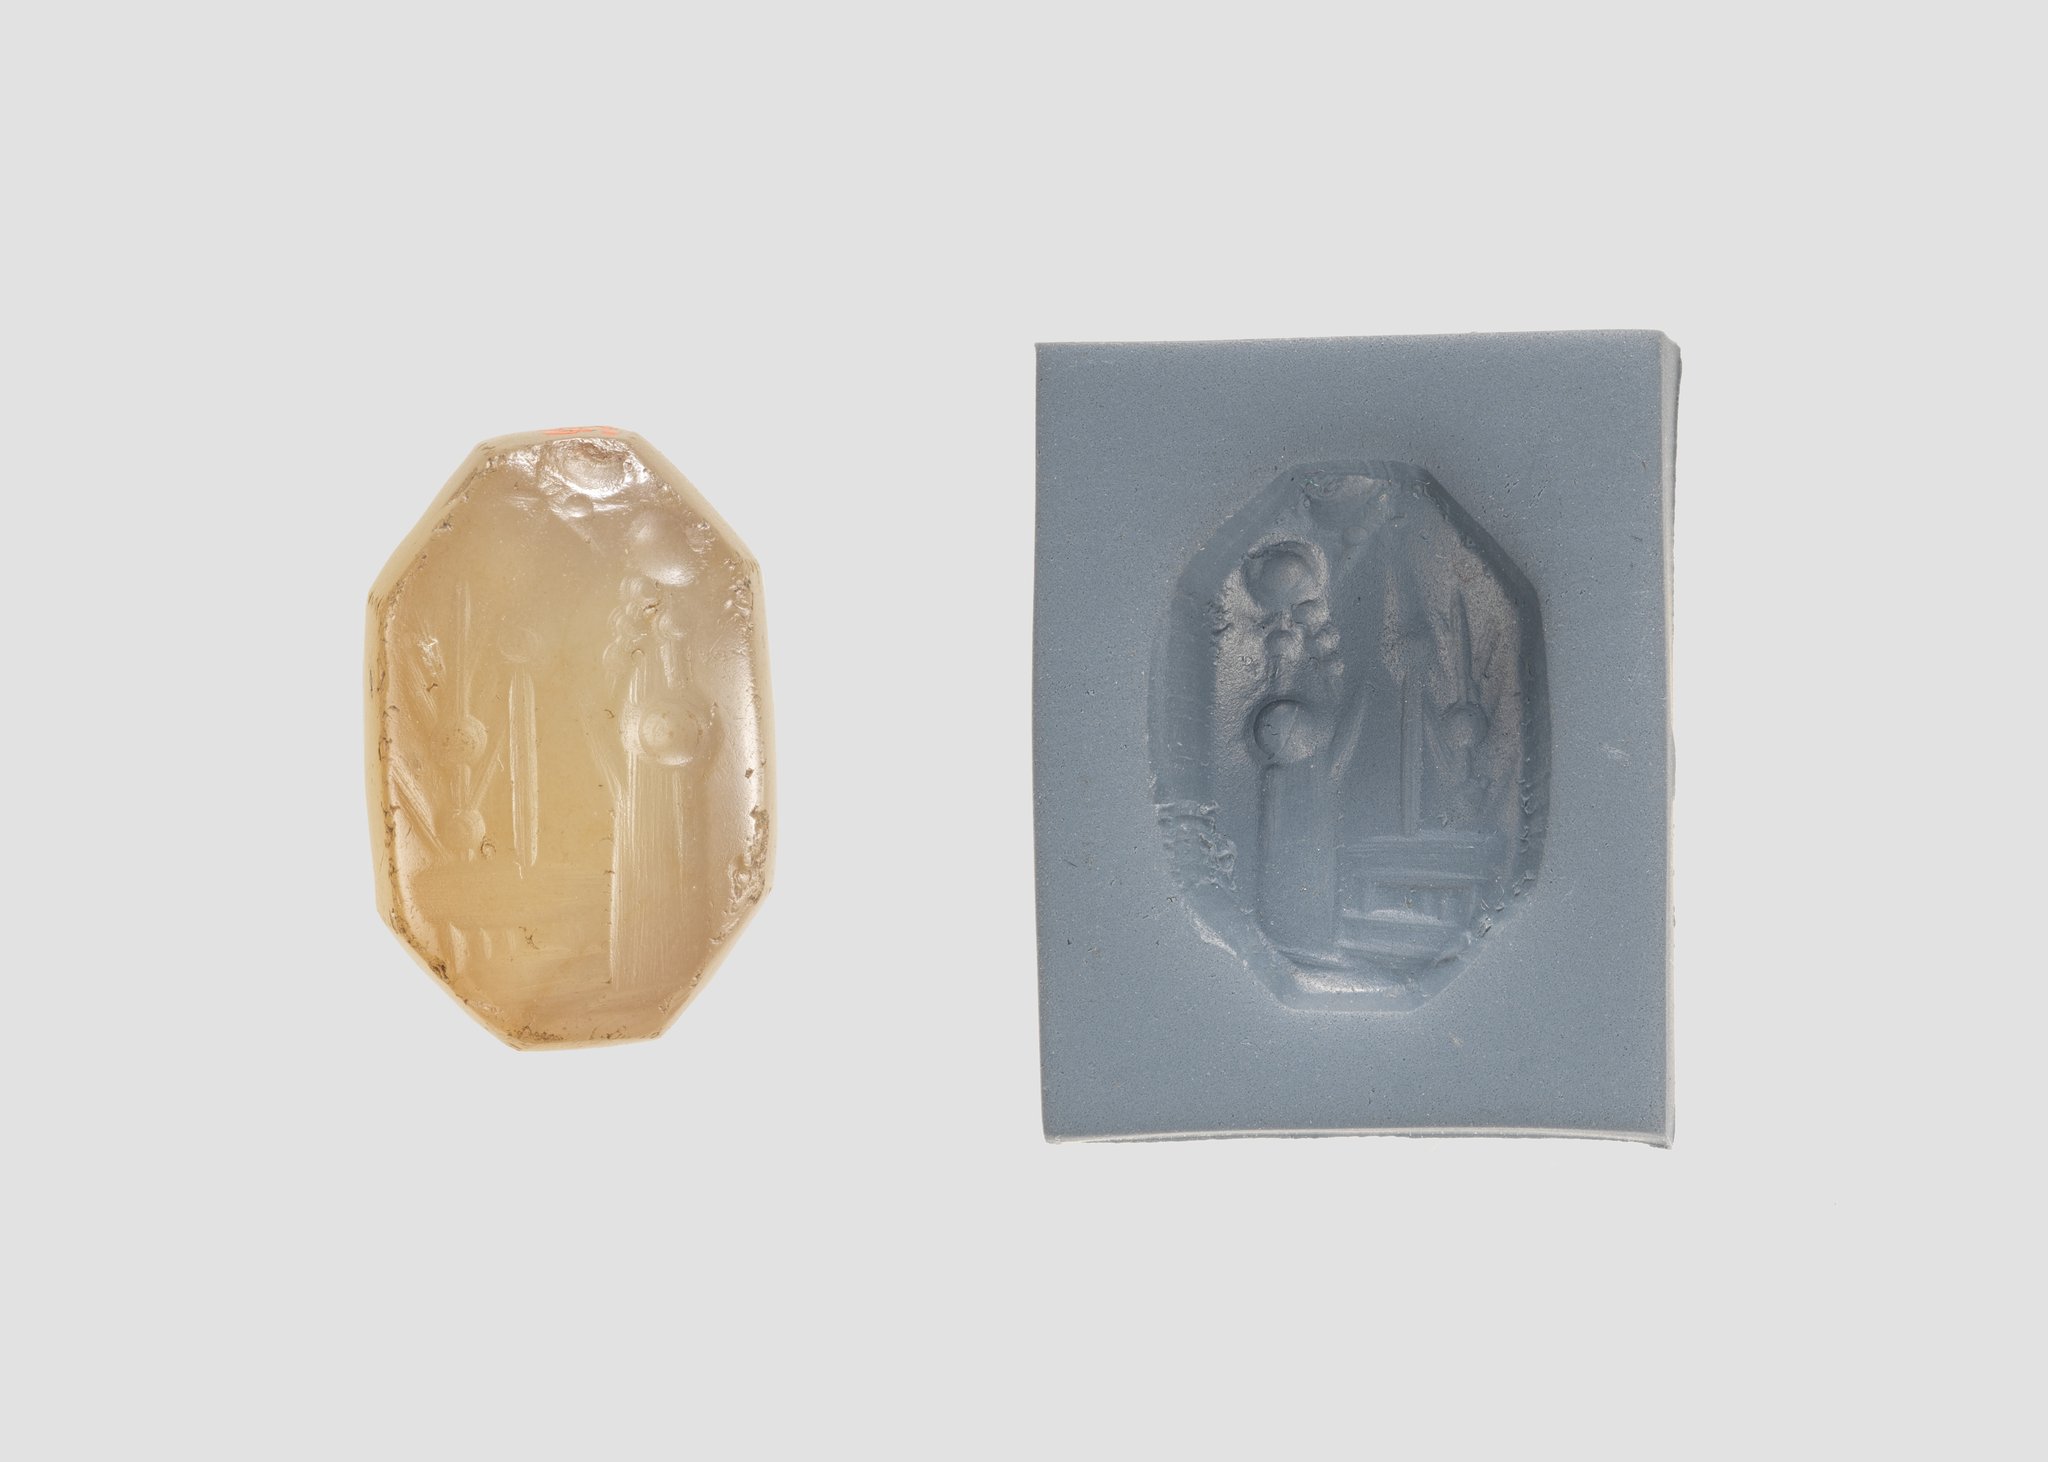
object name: stamp seal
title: Stamp seal (octagonal pyramid) with cultic scene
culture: assyro-babylonian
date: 700-501 BCE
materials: stone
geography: mesopotamia